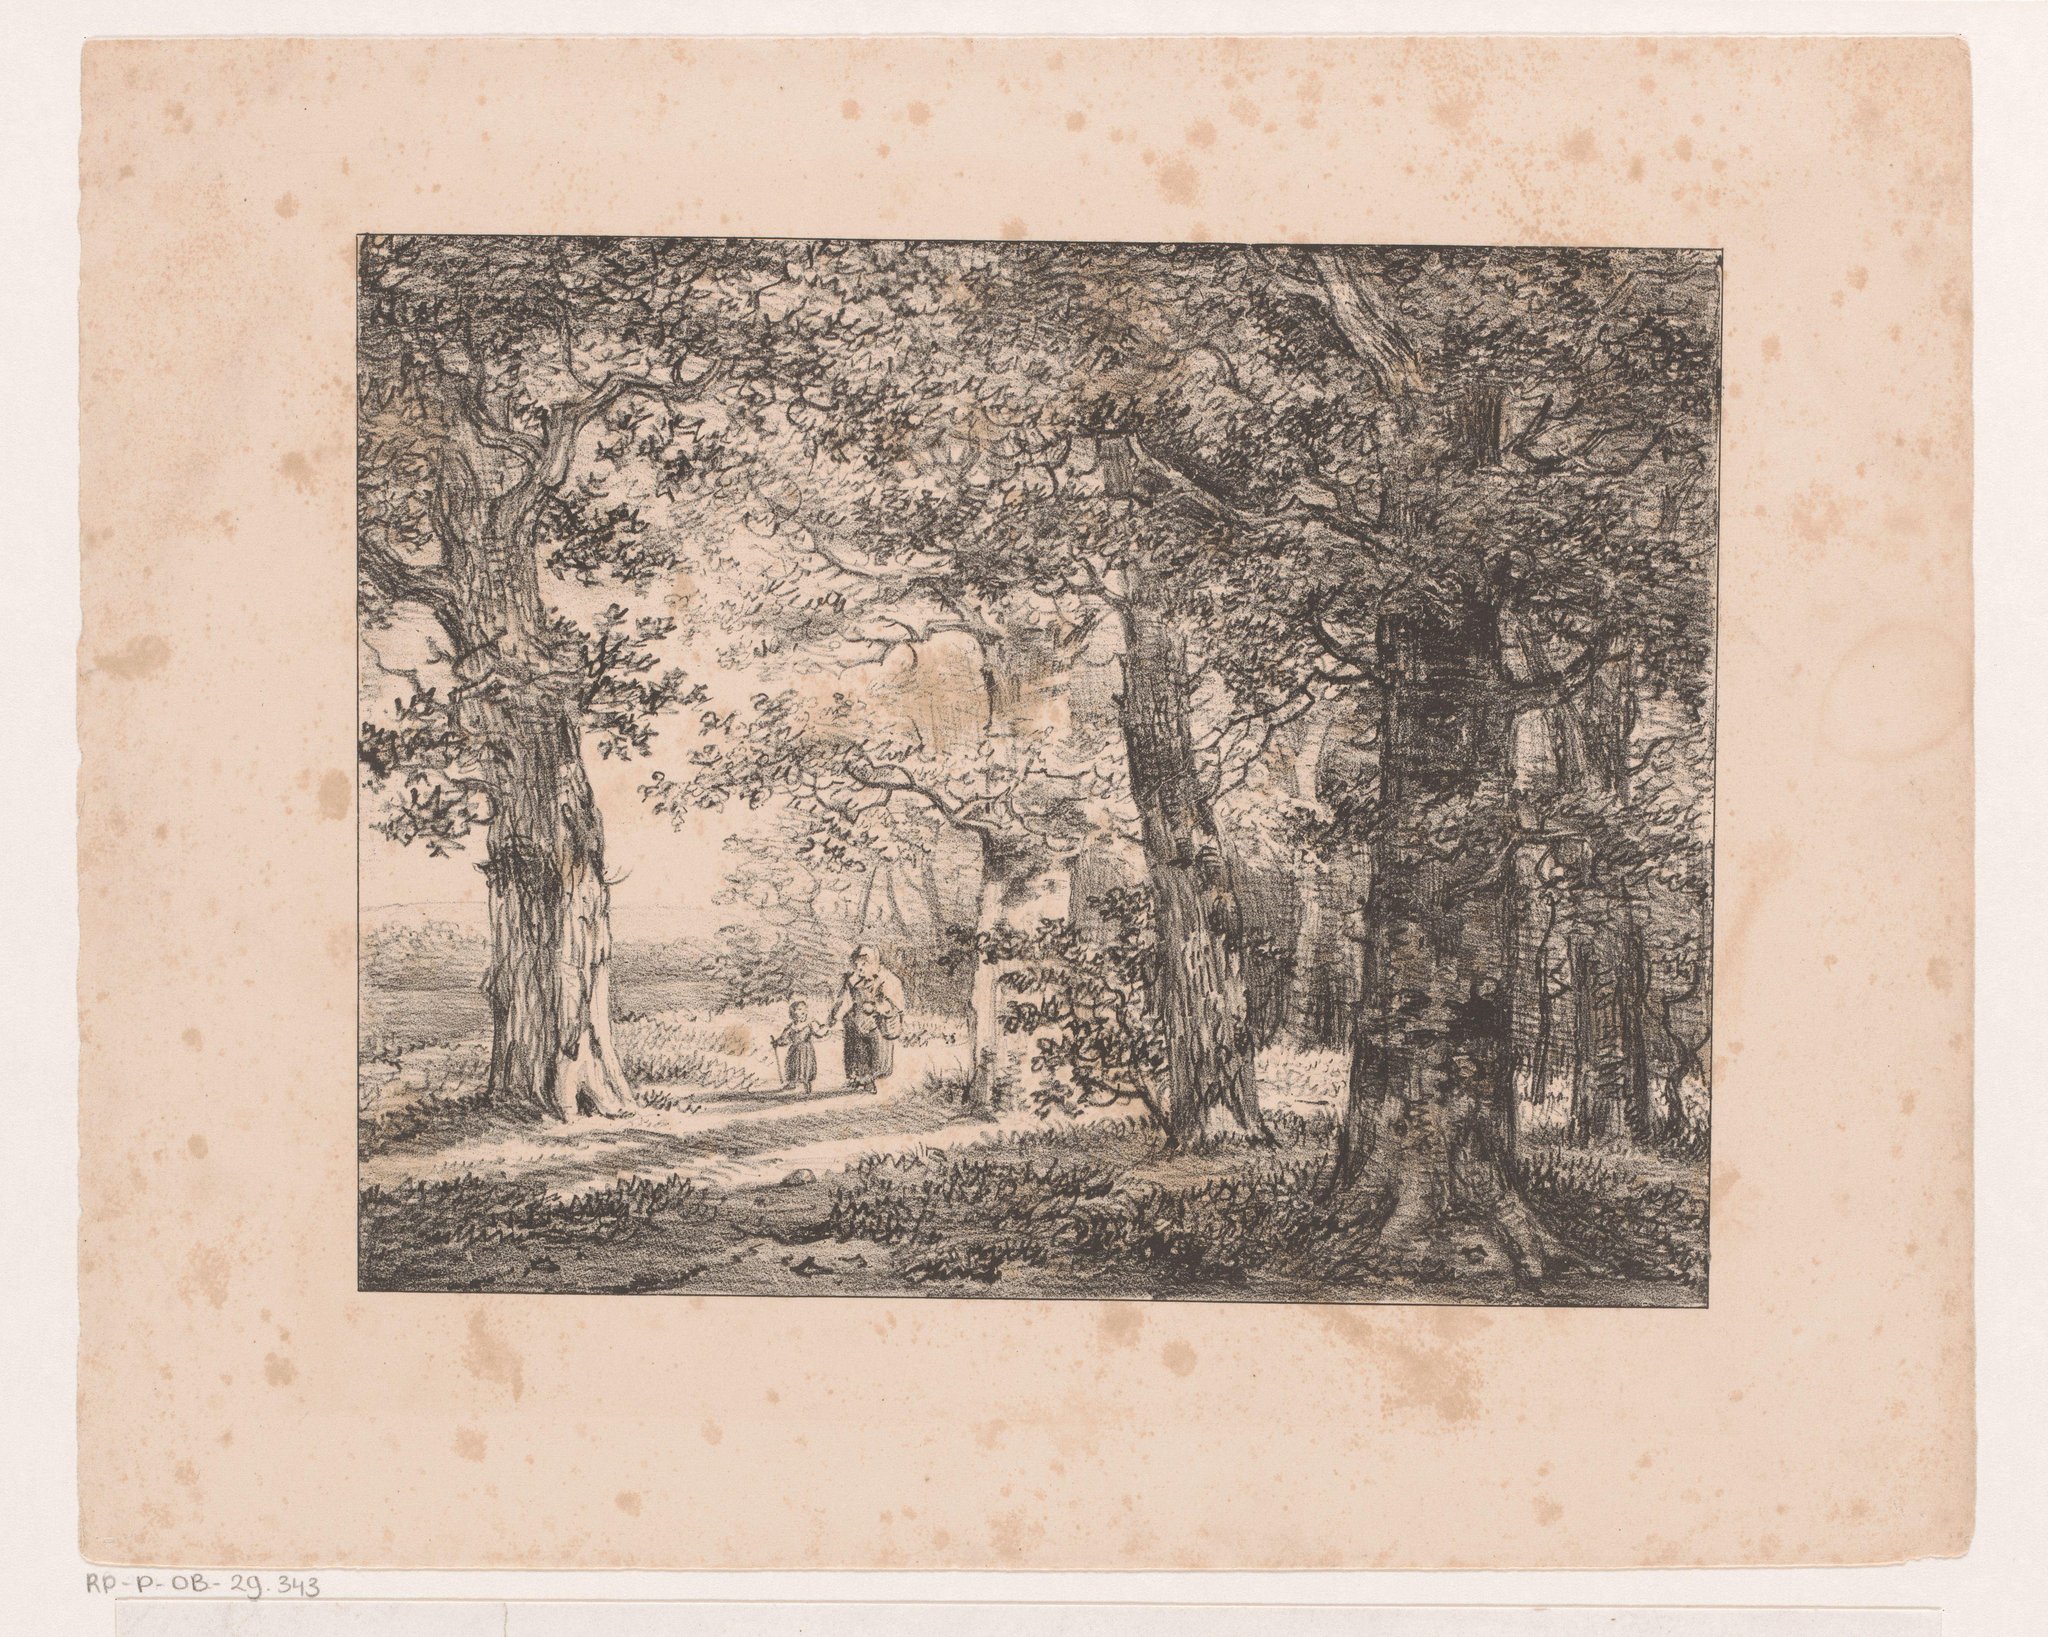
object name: print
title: Vrouw en kind in bos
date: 1809-1872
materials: paper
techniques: lithograph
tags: forest, wood, mother and child(ren), woman and child(ren) (family group)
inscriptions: collector's mark: Lugt 2228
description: Een vrouw met mand loopt met een kind met een stok op een pad in een bos.